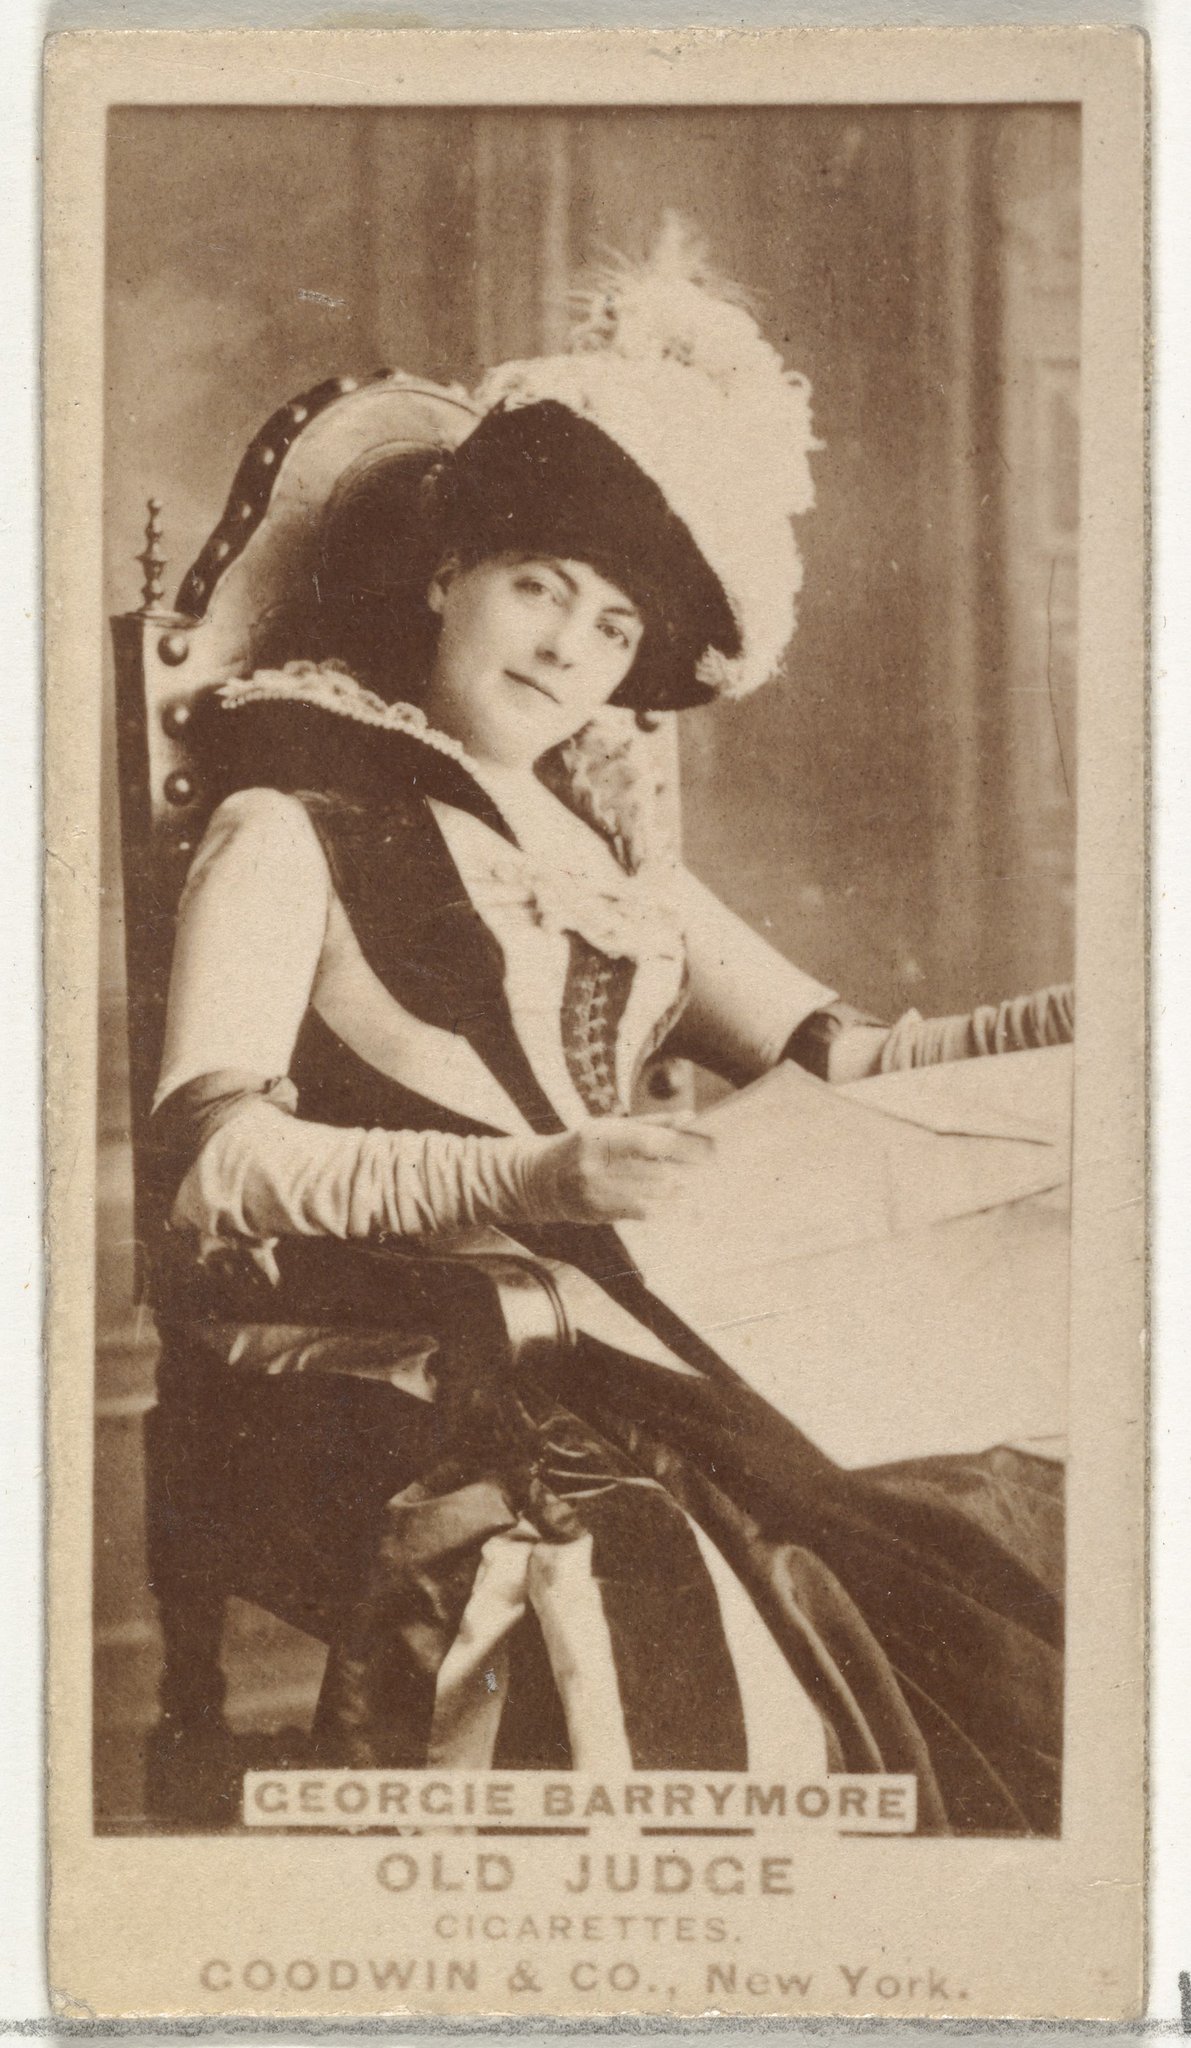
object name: photograph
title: Georgie Barrymore, from the Actors and Actresses series (N171) for Old Judge Cigarettes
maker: goodwin & company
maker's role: publisher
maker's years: 1850-1950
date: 1886-1890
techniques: albumen silver print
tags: portraits,women,actresses